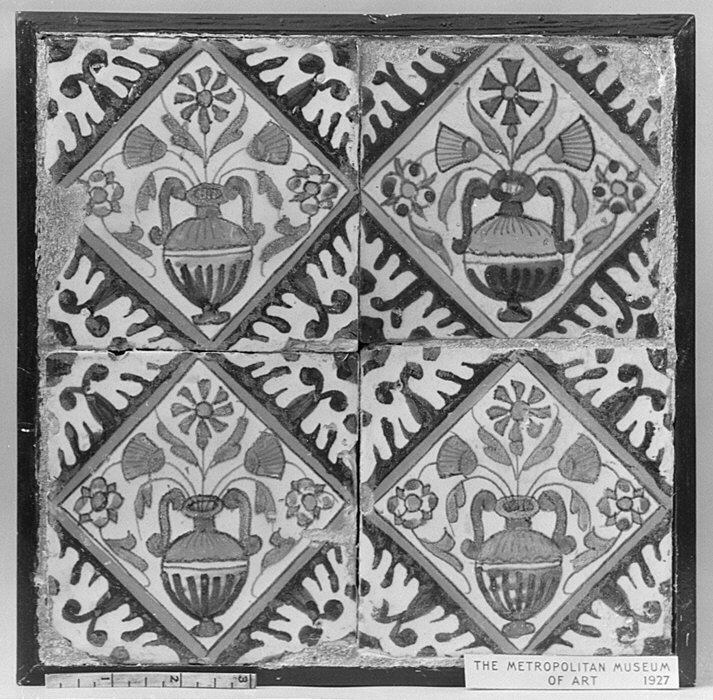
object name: tile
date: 1580-1620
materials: earthenware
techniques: glazing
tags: flowers